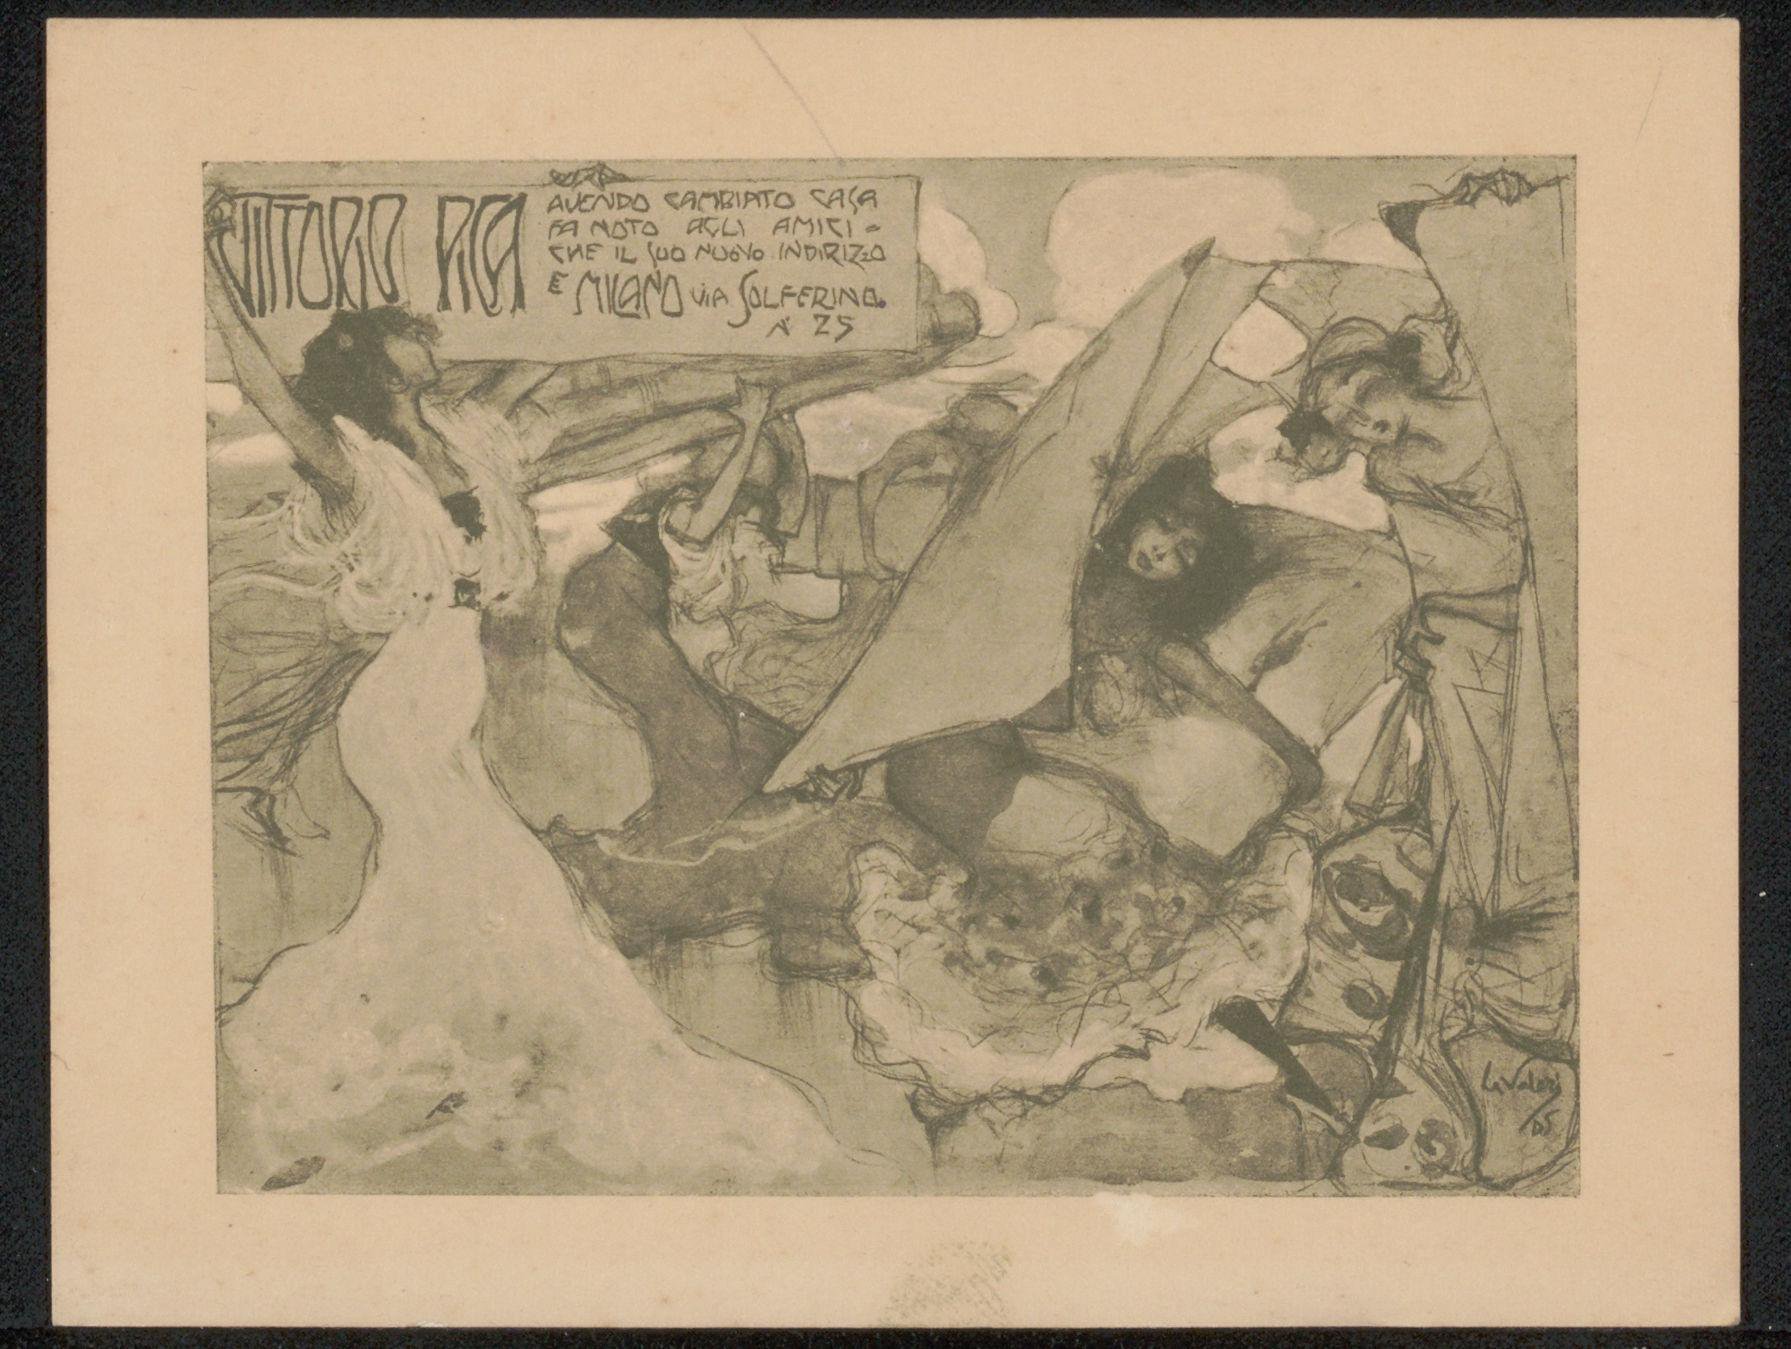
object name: business card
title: Adreskaart uit archief Philip Zilcken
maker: vittorio pica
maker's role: criticus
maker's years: 1864-1930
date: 1905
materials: paper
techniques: printing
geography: milan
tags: the hague, painter, philip zilcken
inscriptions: collector's mark: ‘RPK’